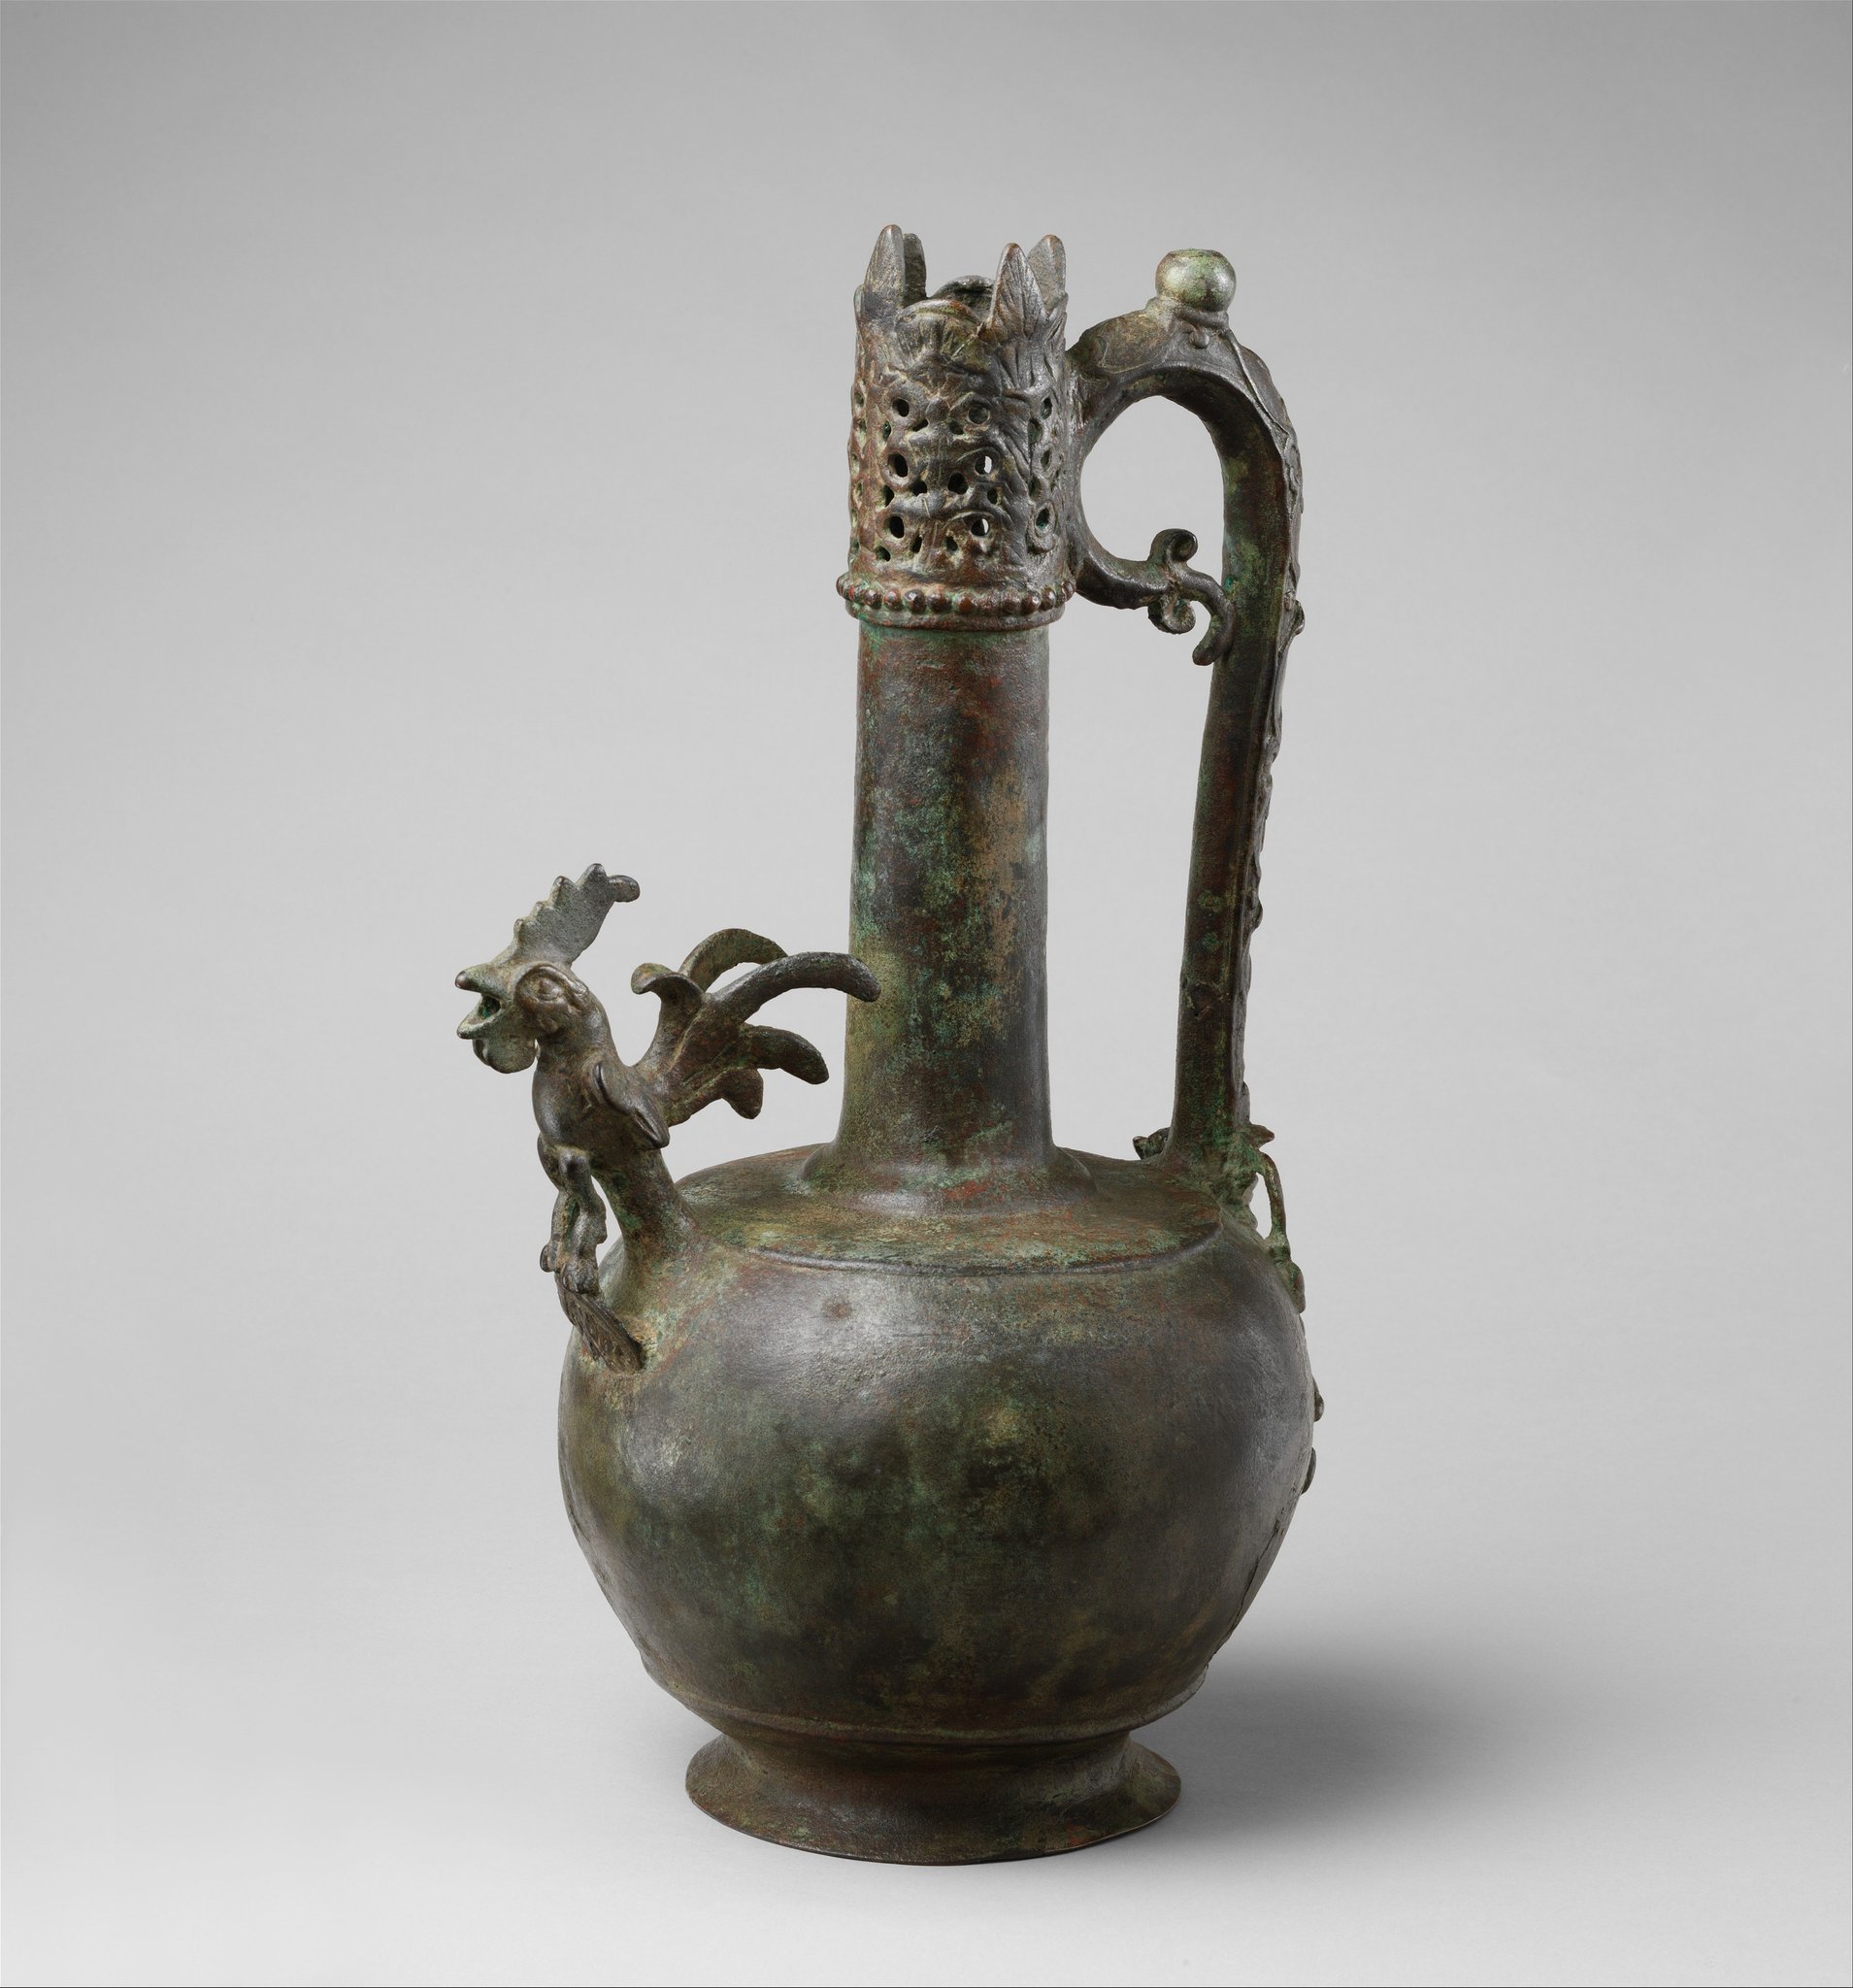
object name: ewer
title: Ewer with a Cock-Shaped Spout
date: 701-833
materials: bronze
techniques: casting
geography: syria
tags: roosters